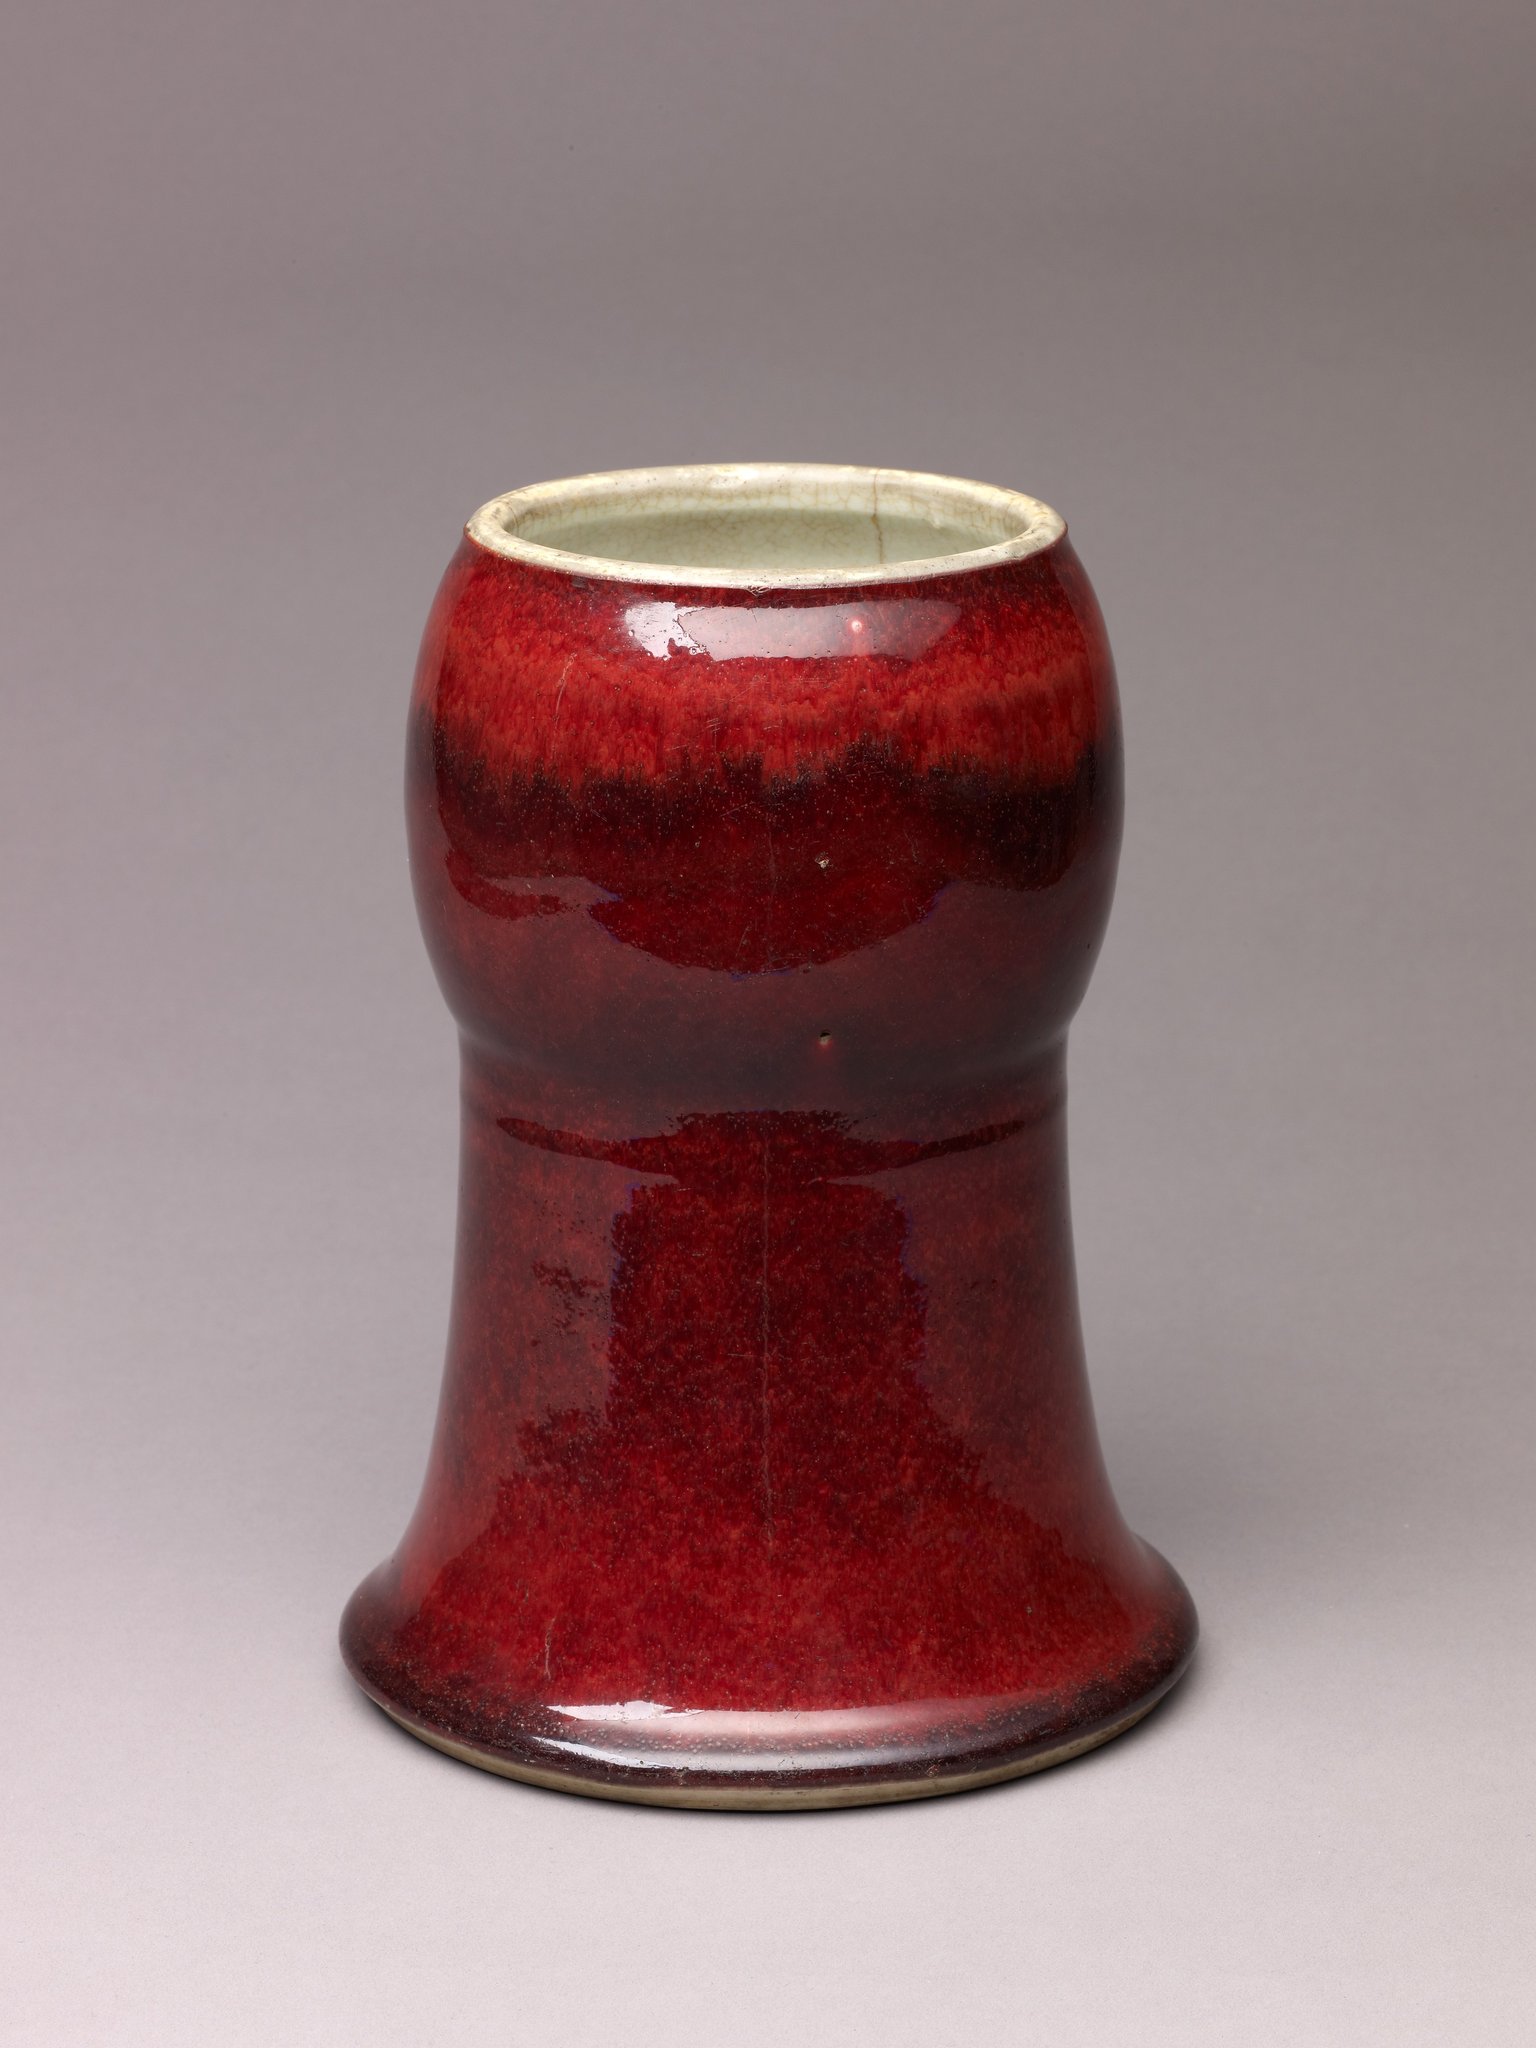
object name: vase bottom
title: Bottom of a vase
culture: chinese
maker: chinese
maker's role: artist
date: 1662-1722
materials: glaze, porcelain